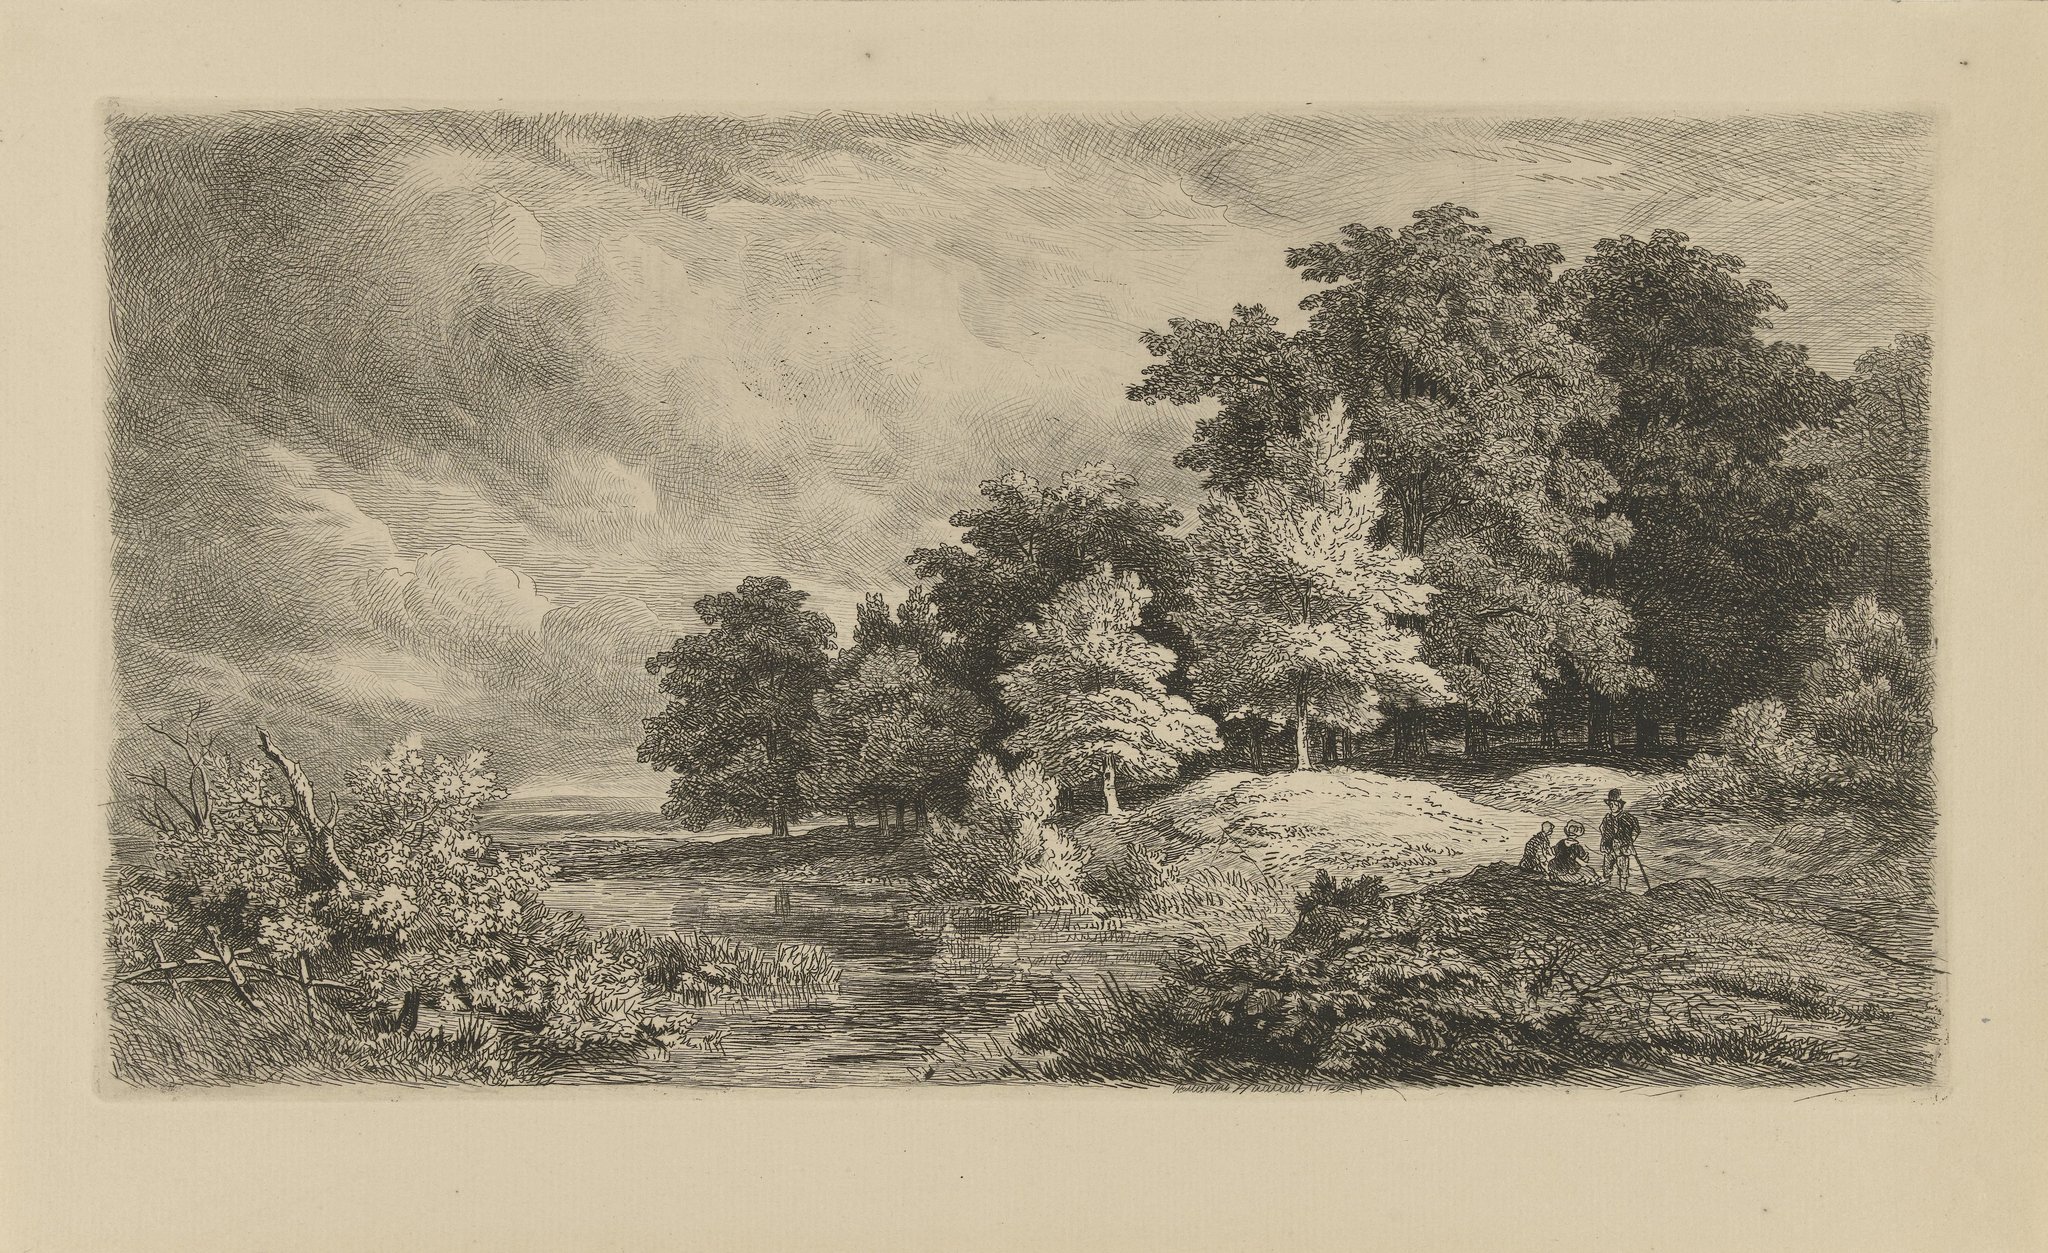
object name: print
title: Landschap met figuren op een bospad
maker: remigius adrianus haanen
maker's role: draughtsman, painter, print maker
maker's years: 1812-1894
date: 1849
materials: paper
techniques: etching, roulette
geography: austria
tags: landscapes with waters, waterscapes, seascapes (in the temperate zone) (+ landscape with figures, staffage)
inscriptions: collector's mark: Lugt 2228